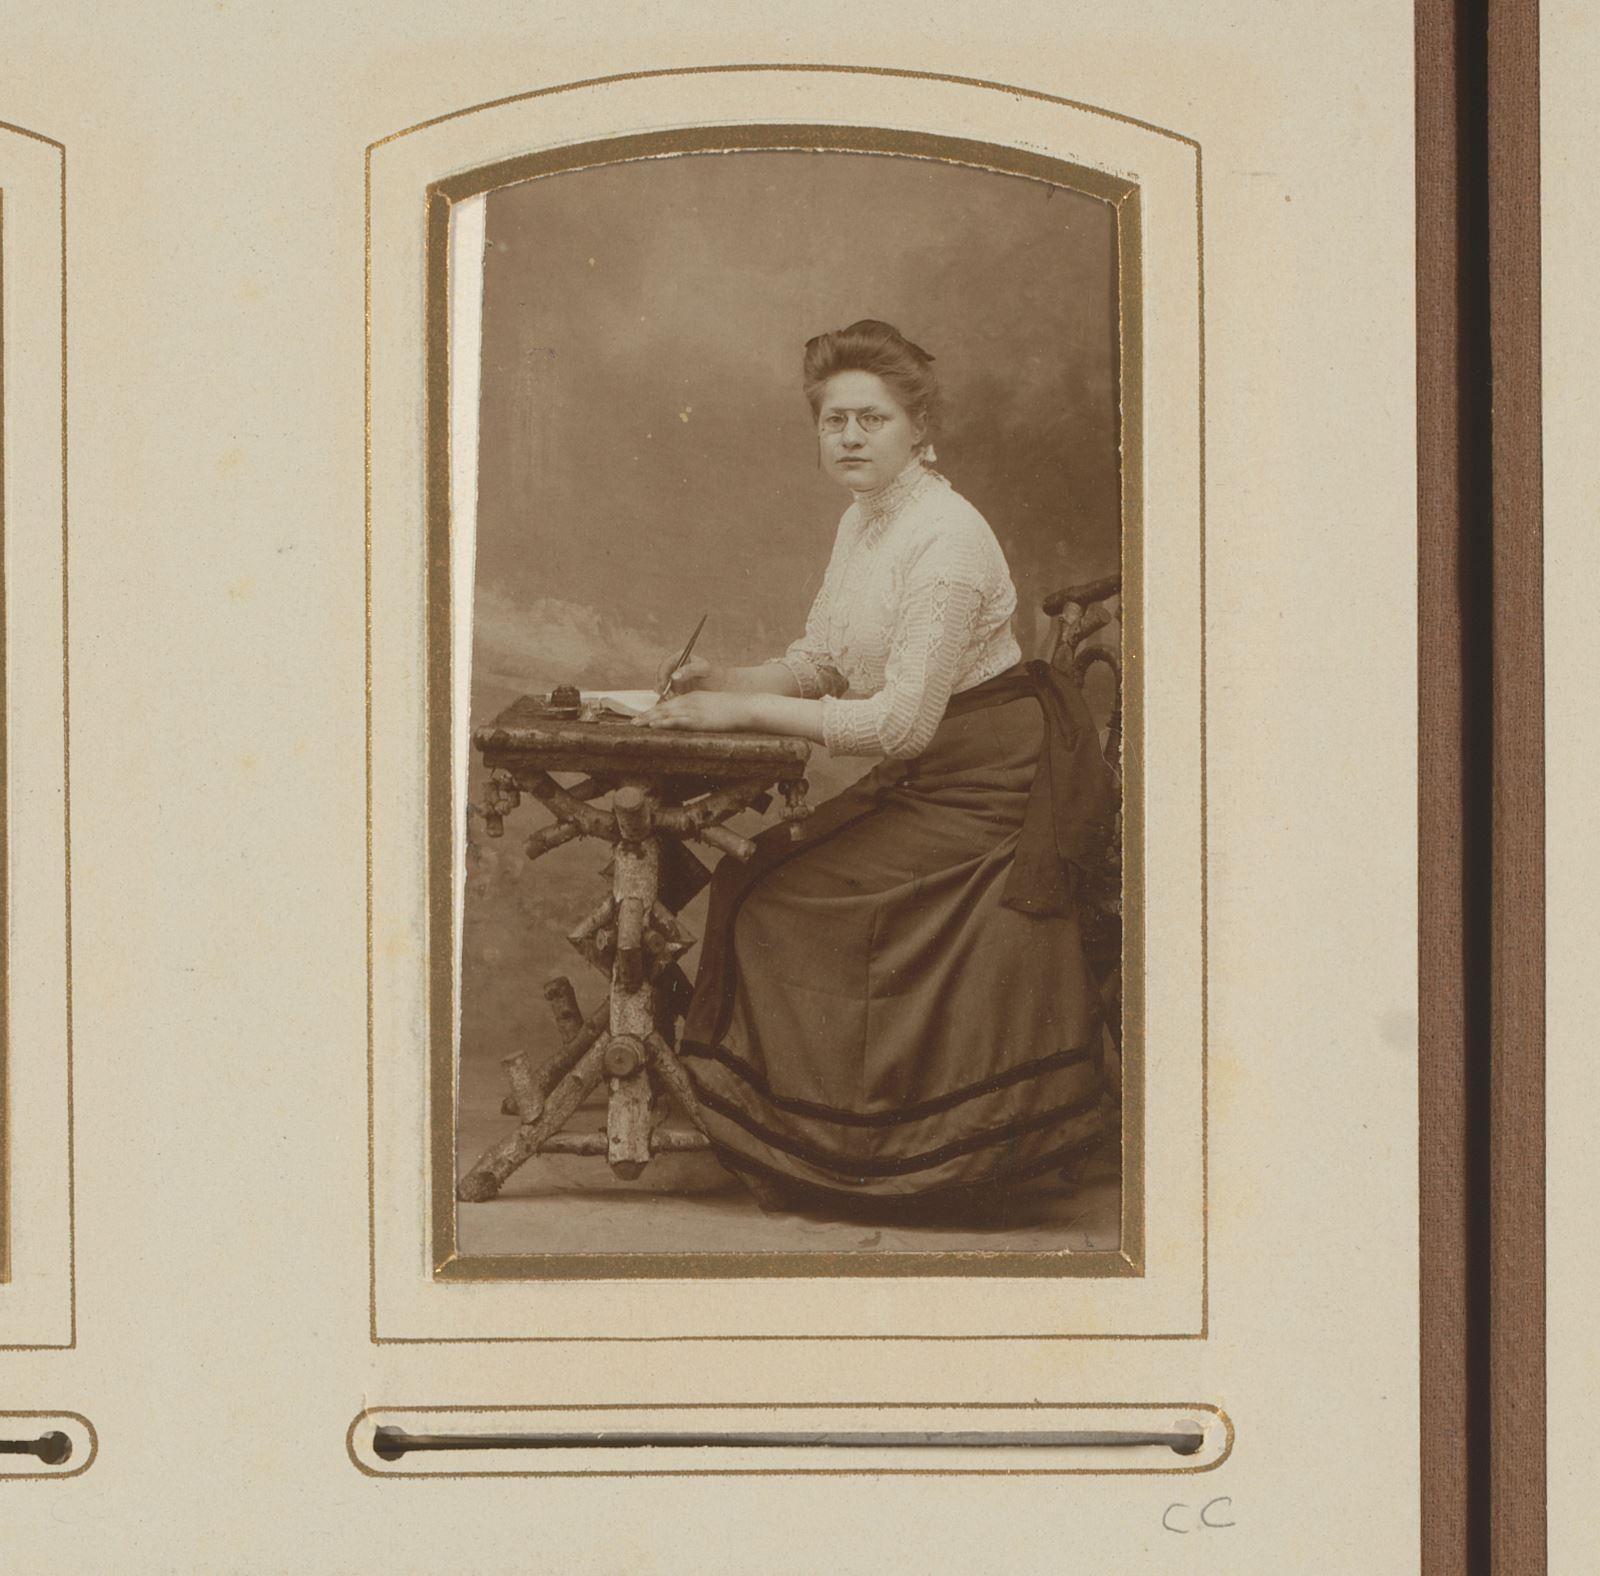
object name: carte de visite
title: Portret van een vrouw met bril, zittend aan een tafel met pen in de hand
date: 1887-1888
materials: cardboard, photographic support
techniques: collodion silver print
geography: amsterdam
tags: eyeglasses, spectacles, sitting figure - aa - female human figure, historical persons - bb - woman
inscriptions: inscription: ‘Fotografie/ Excelsior/ Amsterdam/ Vijzelgracht 41.’